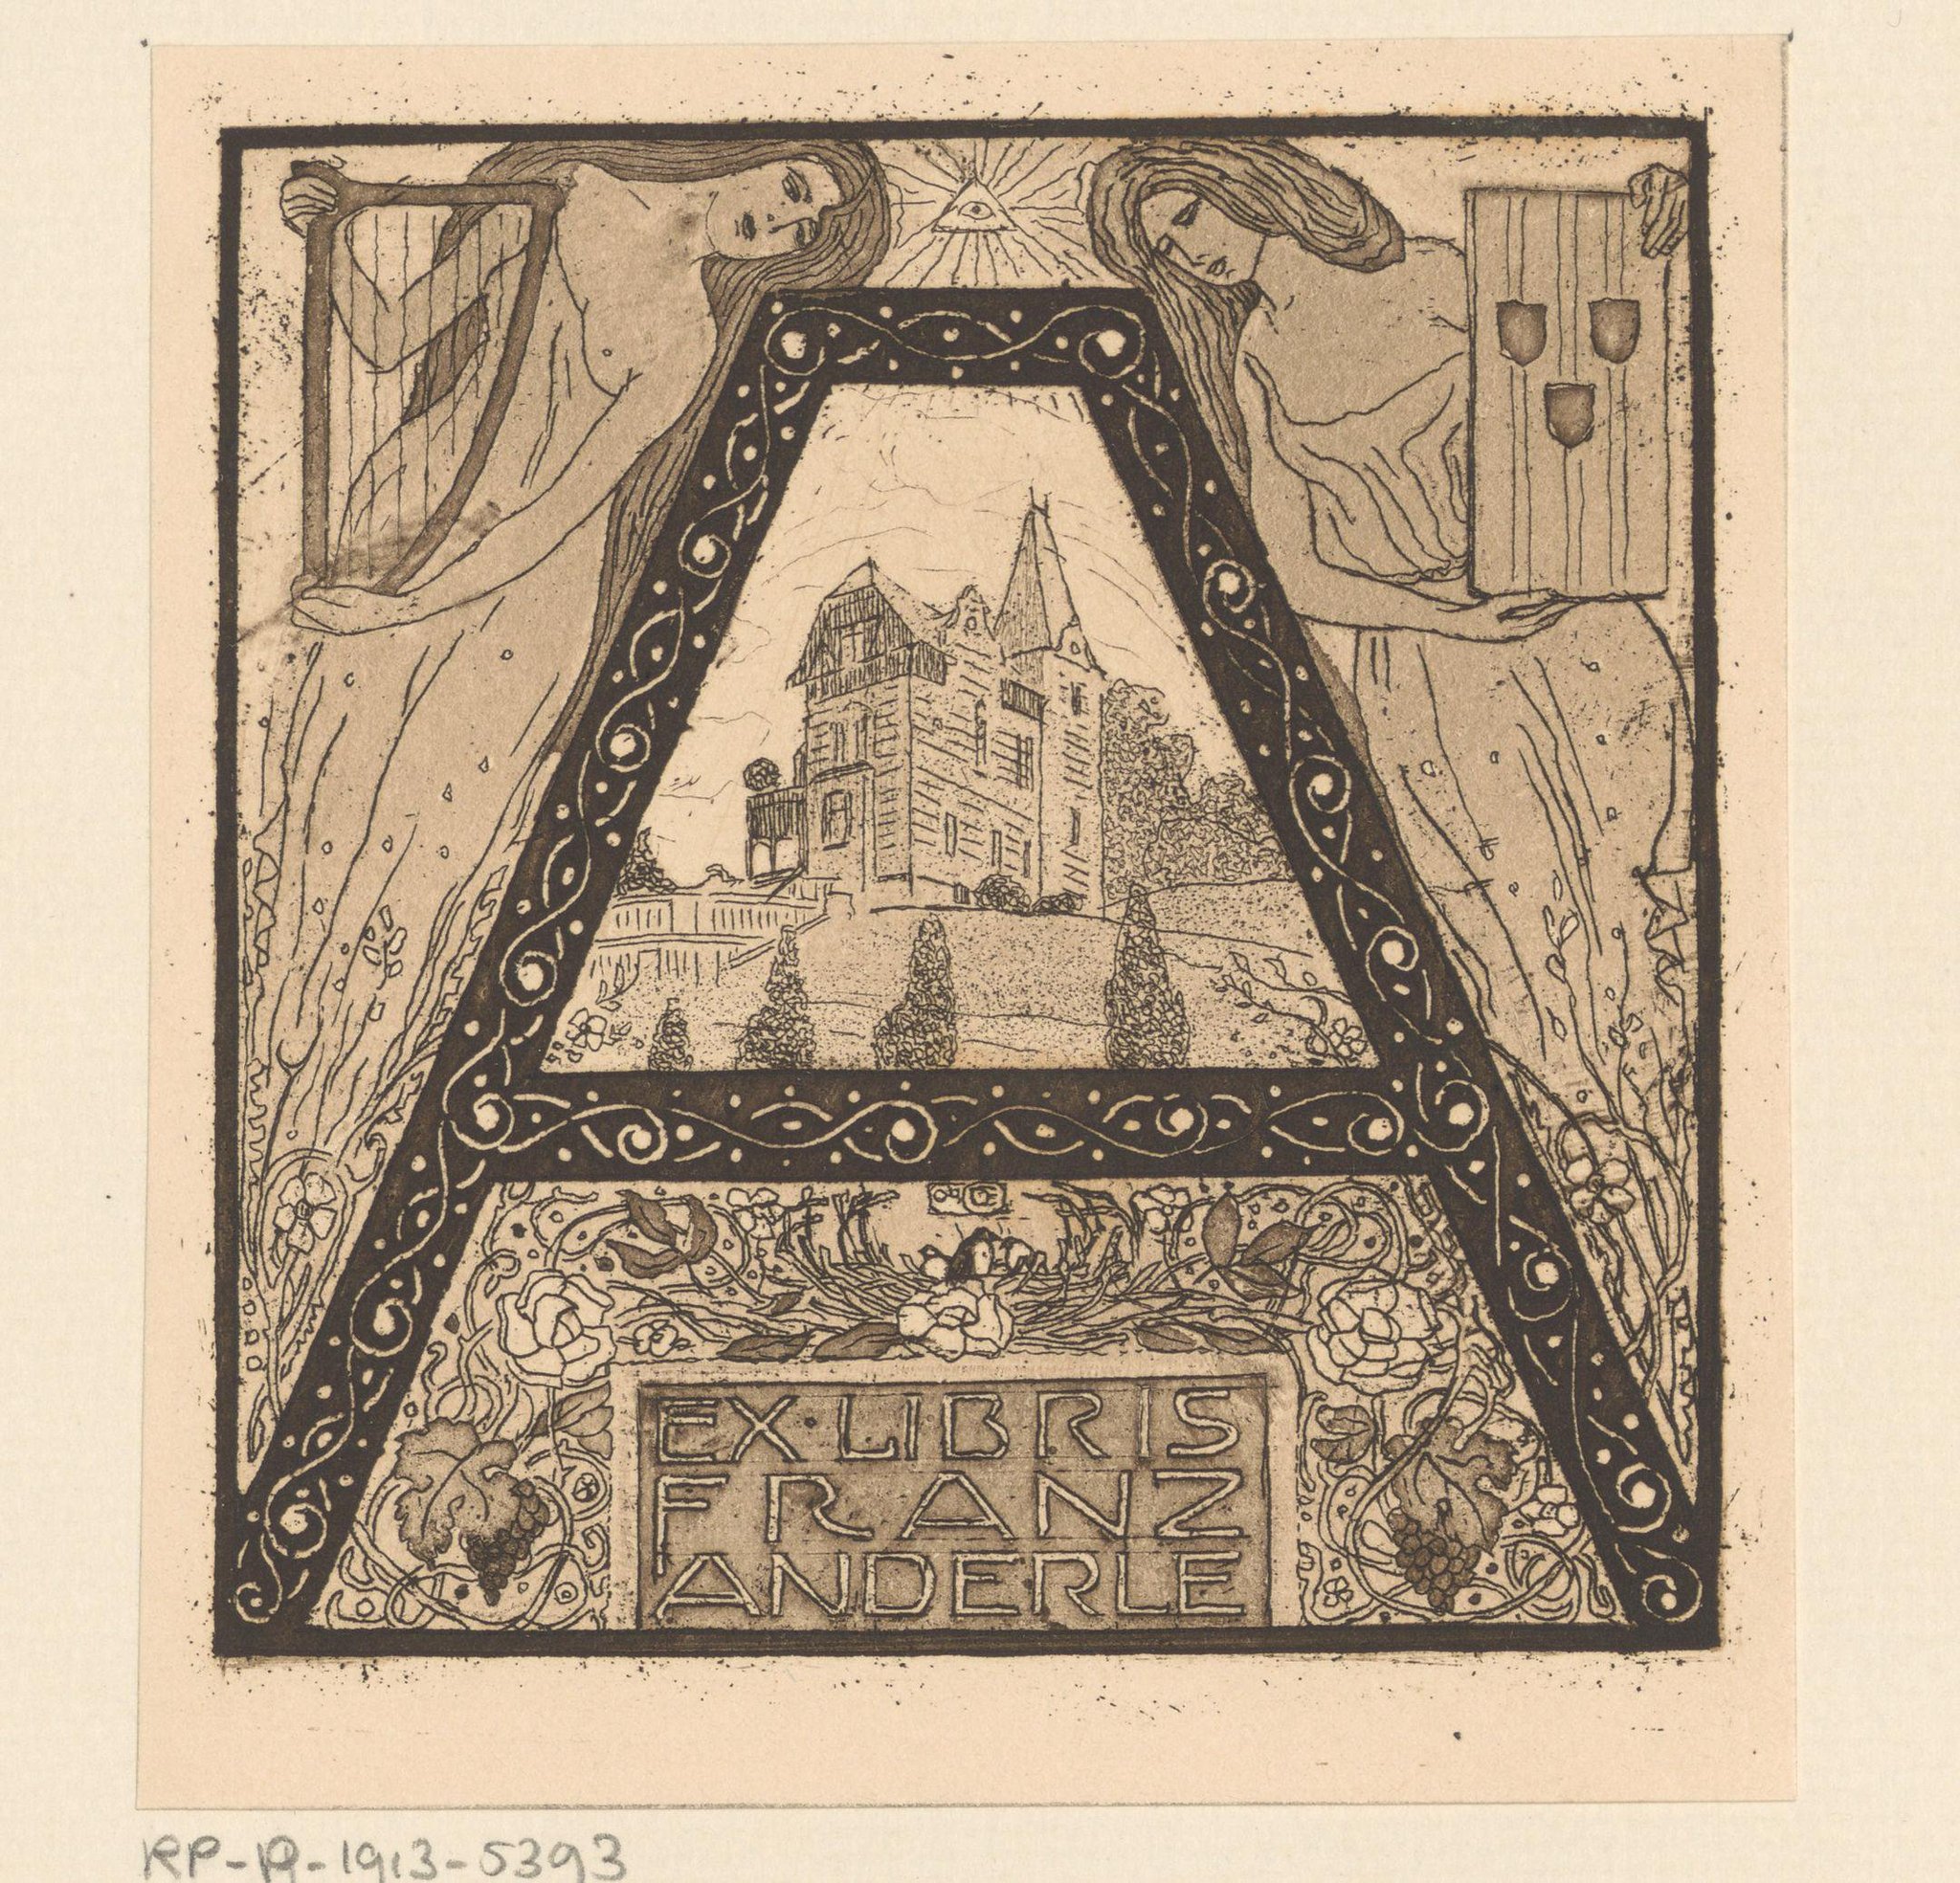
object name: bookplate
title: Ex libris van Franz Anderle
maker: emil orlik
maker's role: painter, print maker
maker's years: 1870-1932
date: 1904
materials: paper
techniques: aquatint, etching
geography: czech republic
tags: vine, adult woman, harp, villa, the all-seeing eye, triangle with eye ~ symbol of god the father, armorial bearing, heraldry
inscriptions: collector's mark: Lugt 2760, collector's mark: Lugt 2233